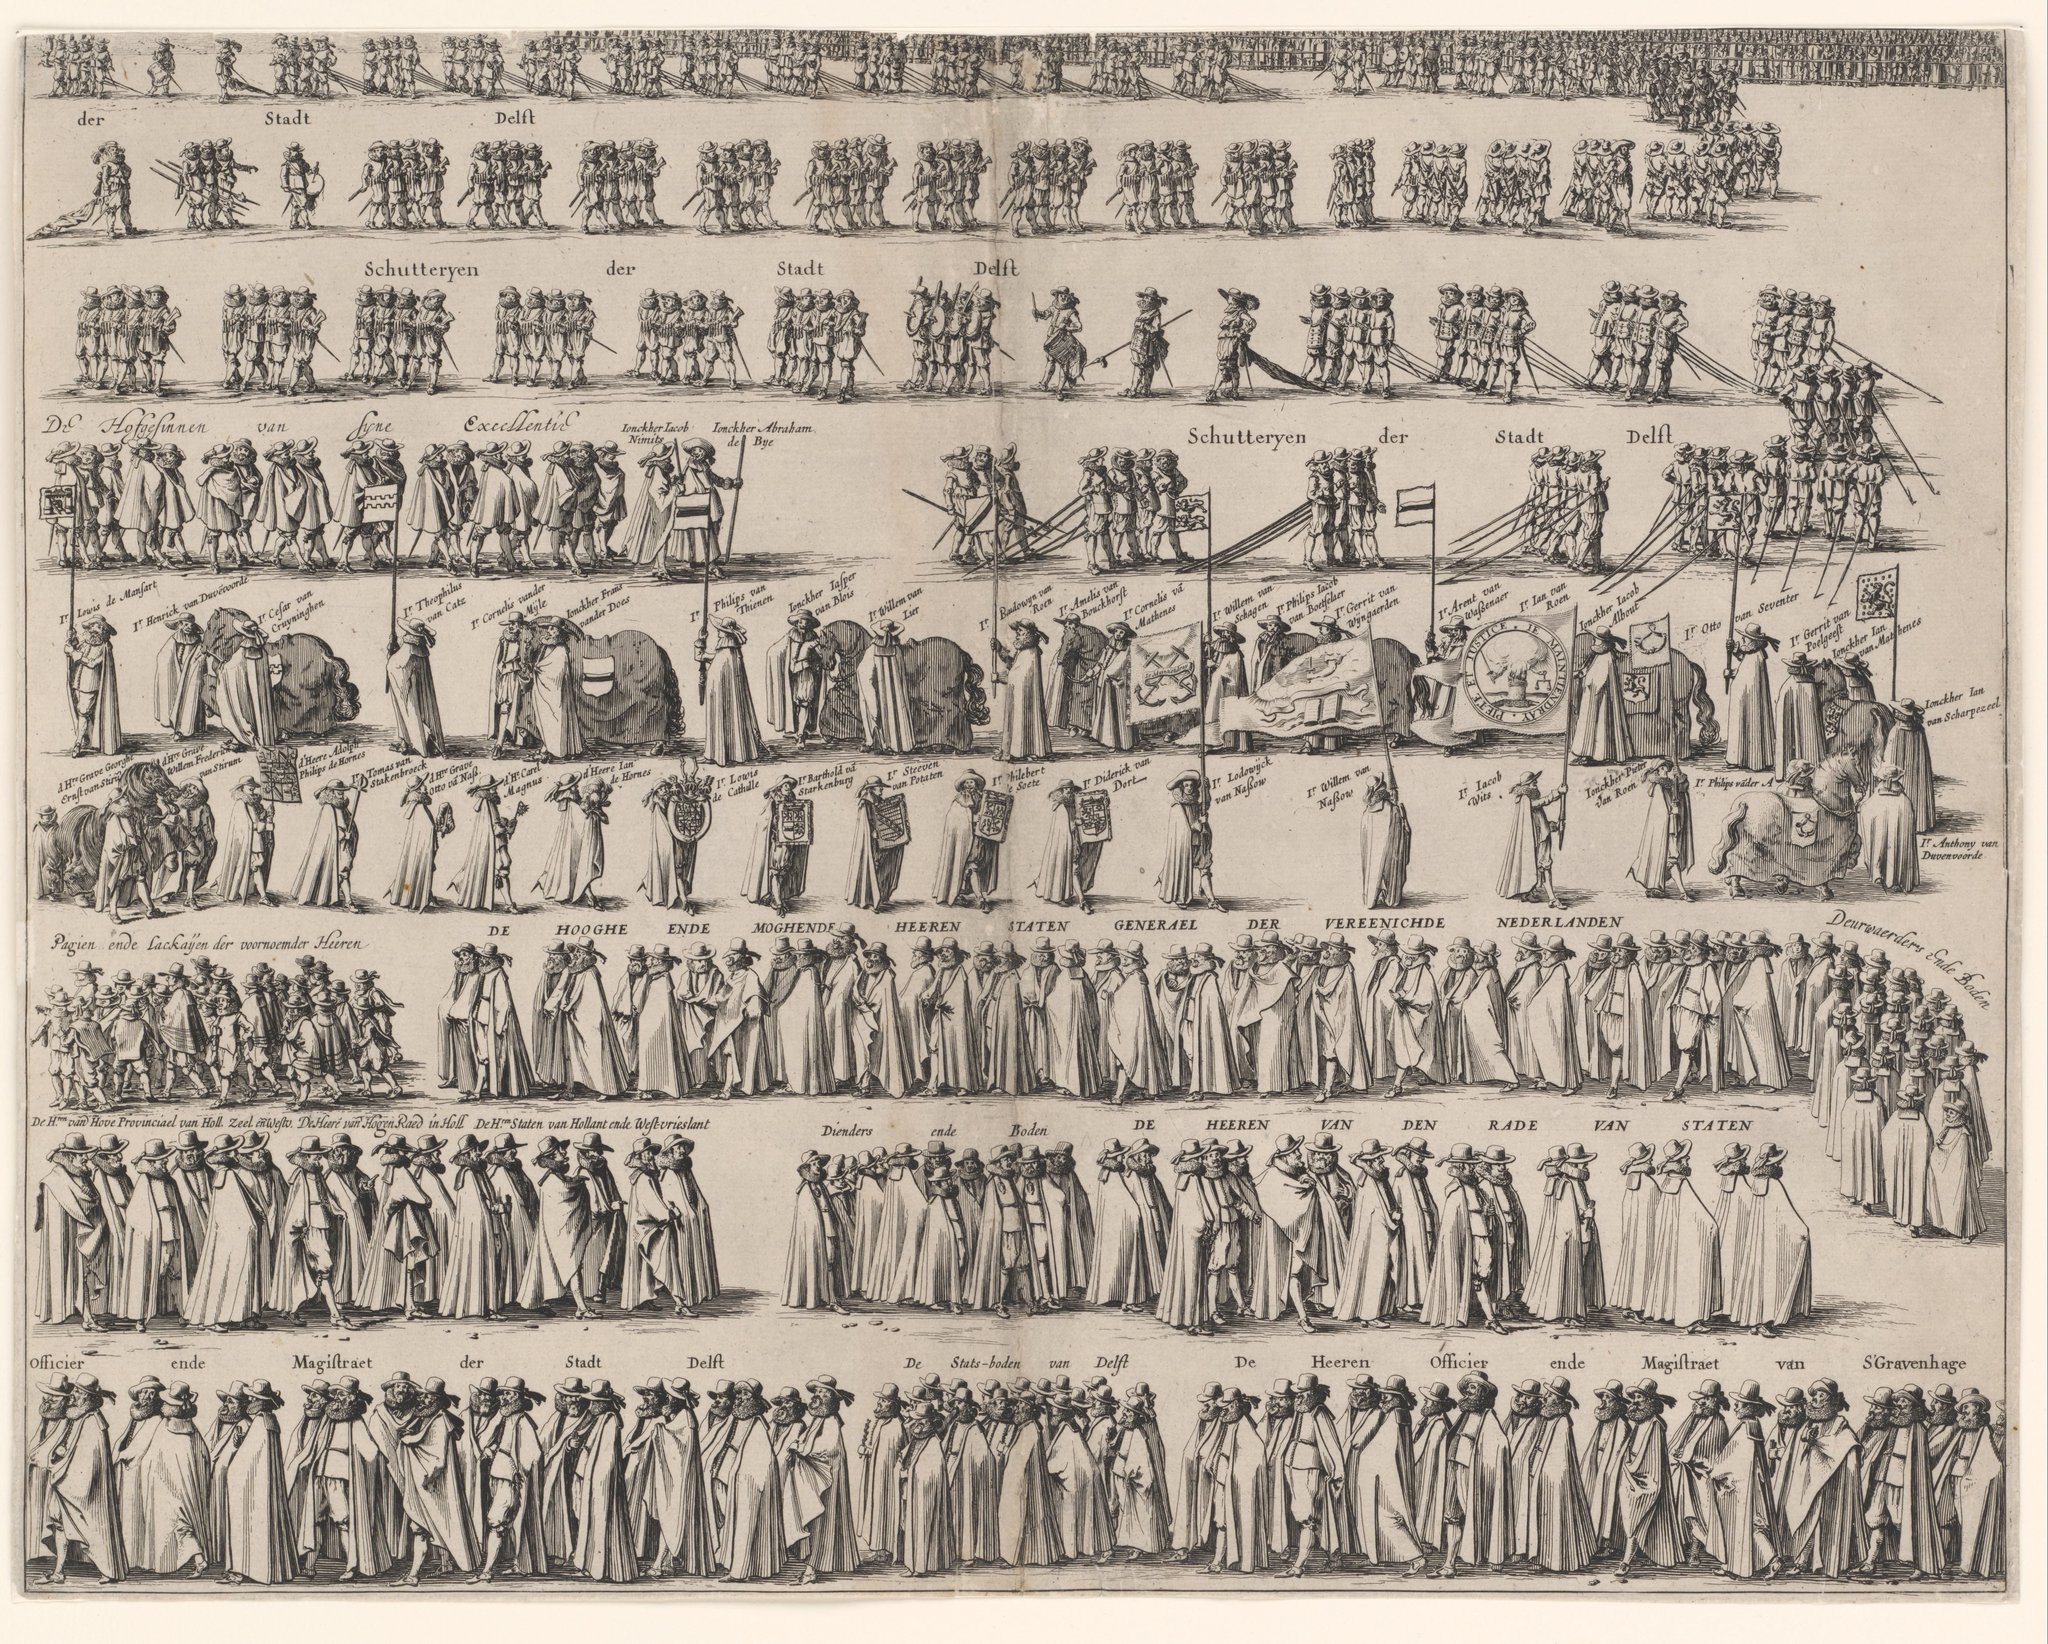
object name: print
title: Lijkstatie van prins Maurits in 1625, deel rechtsonder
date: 1625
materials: paper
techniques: etching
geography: amsterdam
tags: the hague, maurice (prince of orange), cortege, funeral procession, delft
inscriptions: collector's mark: Lugt 963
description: De begrafenisstoet van prins Maurits te Delft op 16 september 1625. Grote voorstelling van de ceremonie, bestaande uit 4 te monteren bladen, een titel en bijbehorende tekstblaadjes (genummerd 1-12). Dit is het blad rechtsonder. De begrafenisstoet slingert zich in negen rijen over de markt, voorop lopen de schutterijen van de stad Delft.